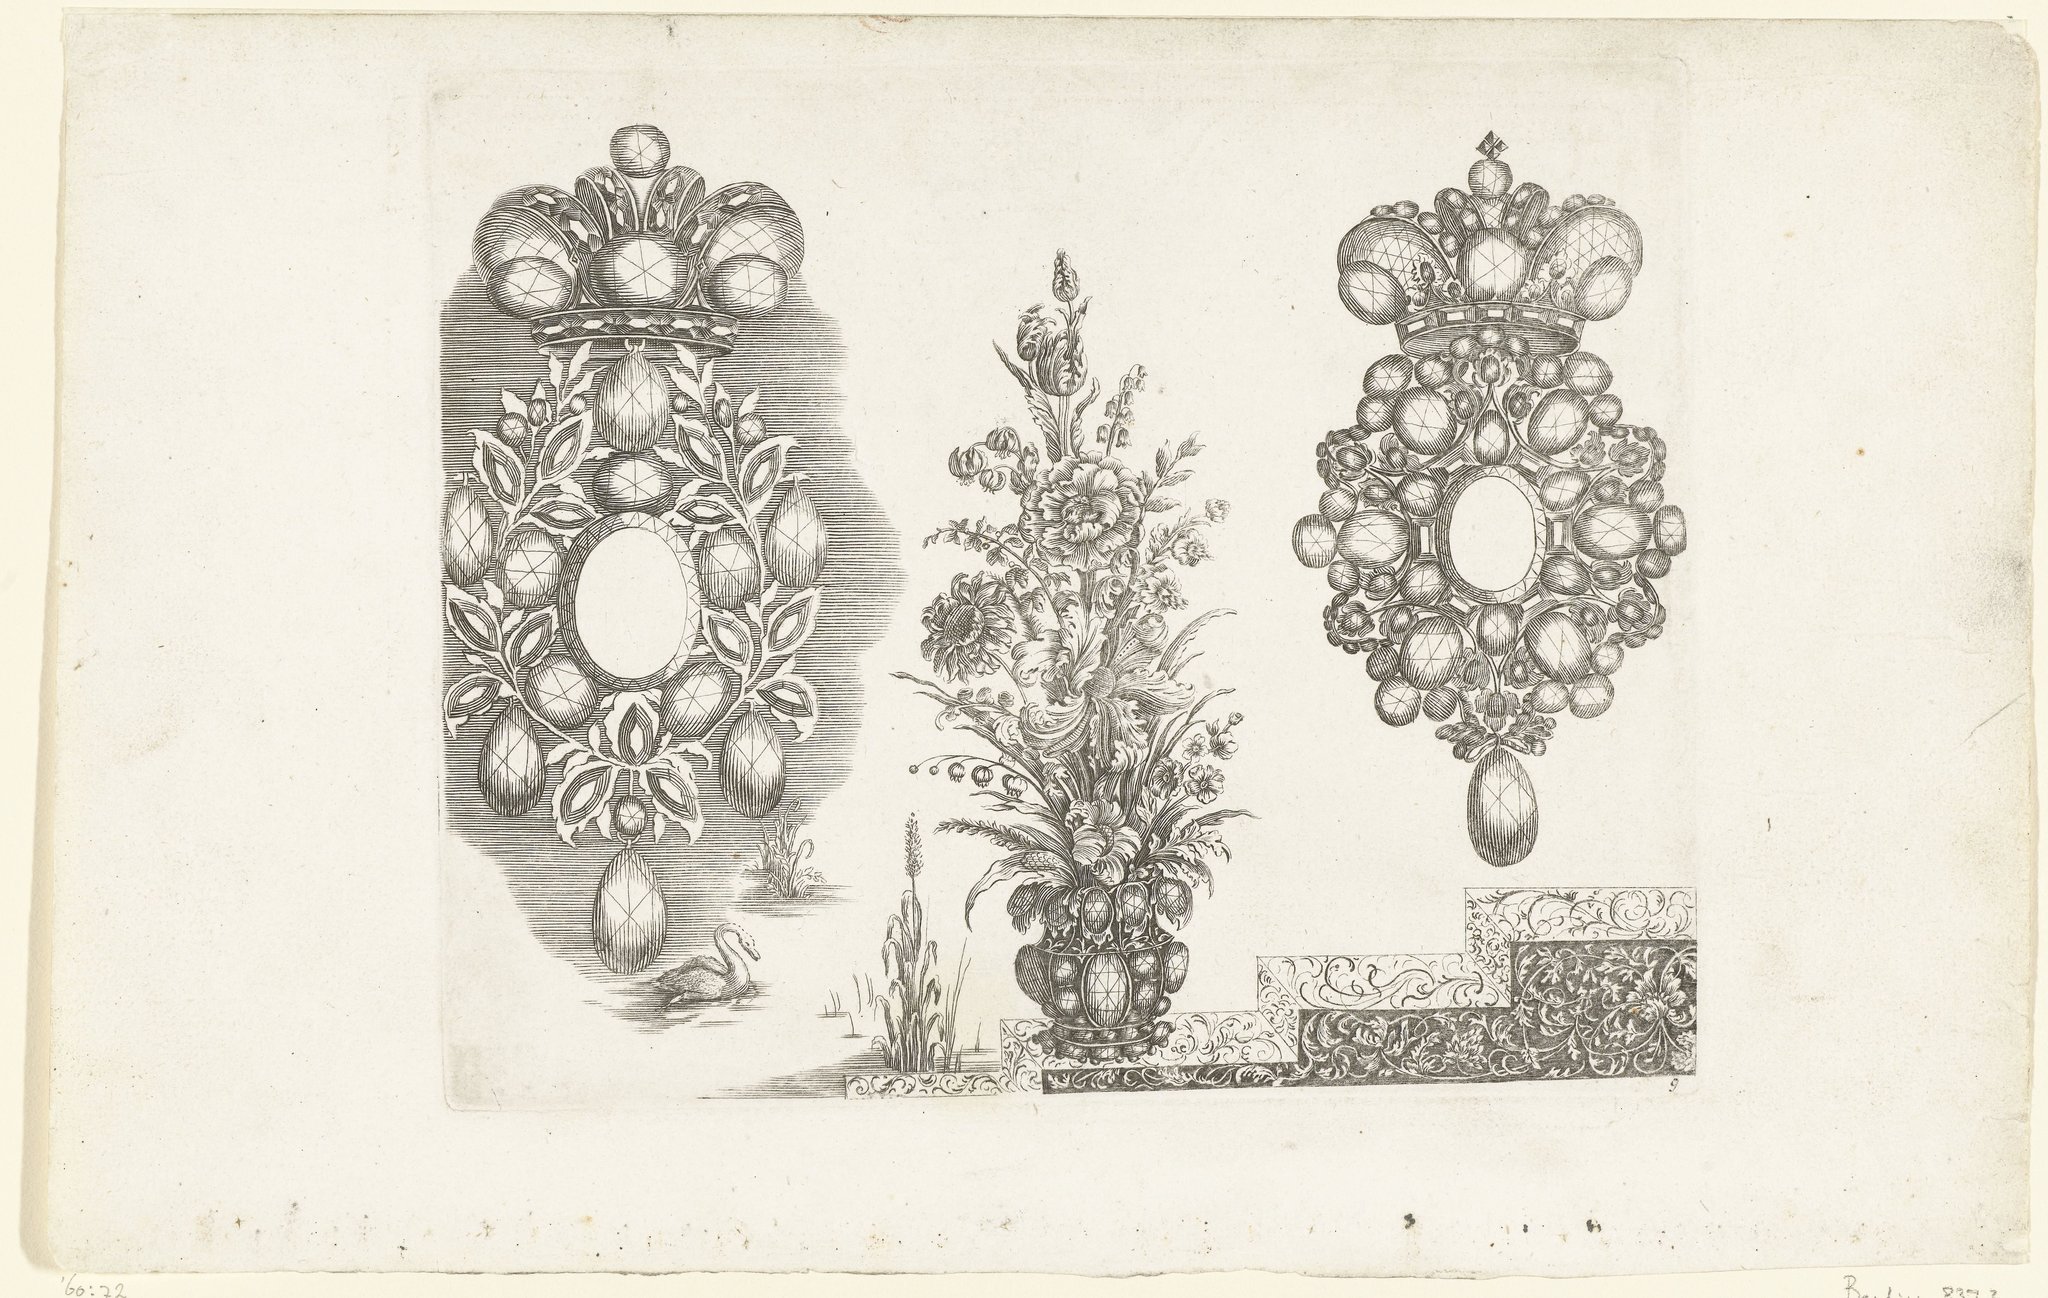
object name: ornament print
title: Twee broches en een vaas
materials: paper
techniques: engraving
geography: amsterdam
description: In het midden staat een vaas bezet met edelstenen met een hoog boeket met bloemen, geflankeerd door twee grote broches met een gesloten kroon.